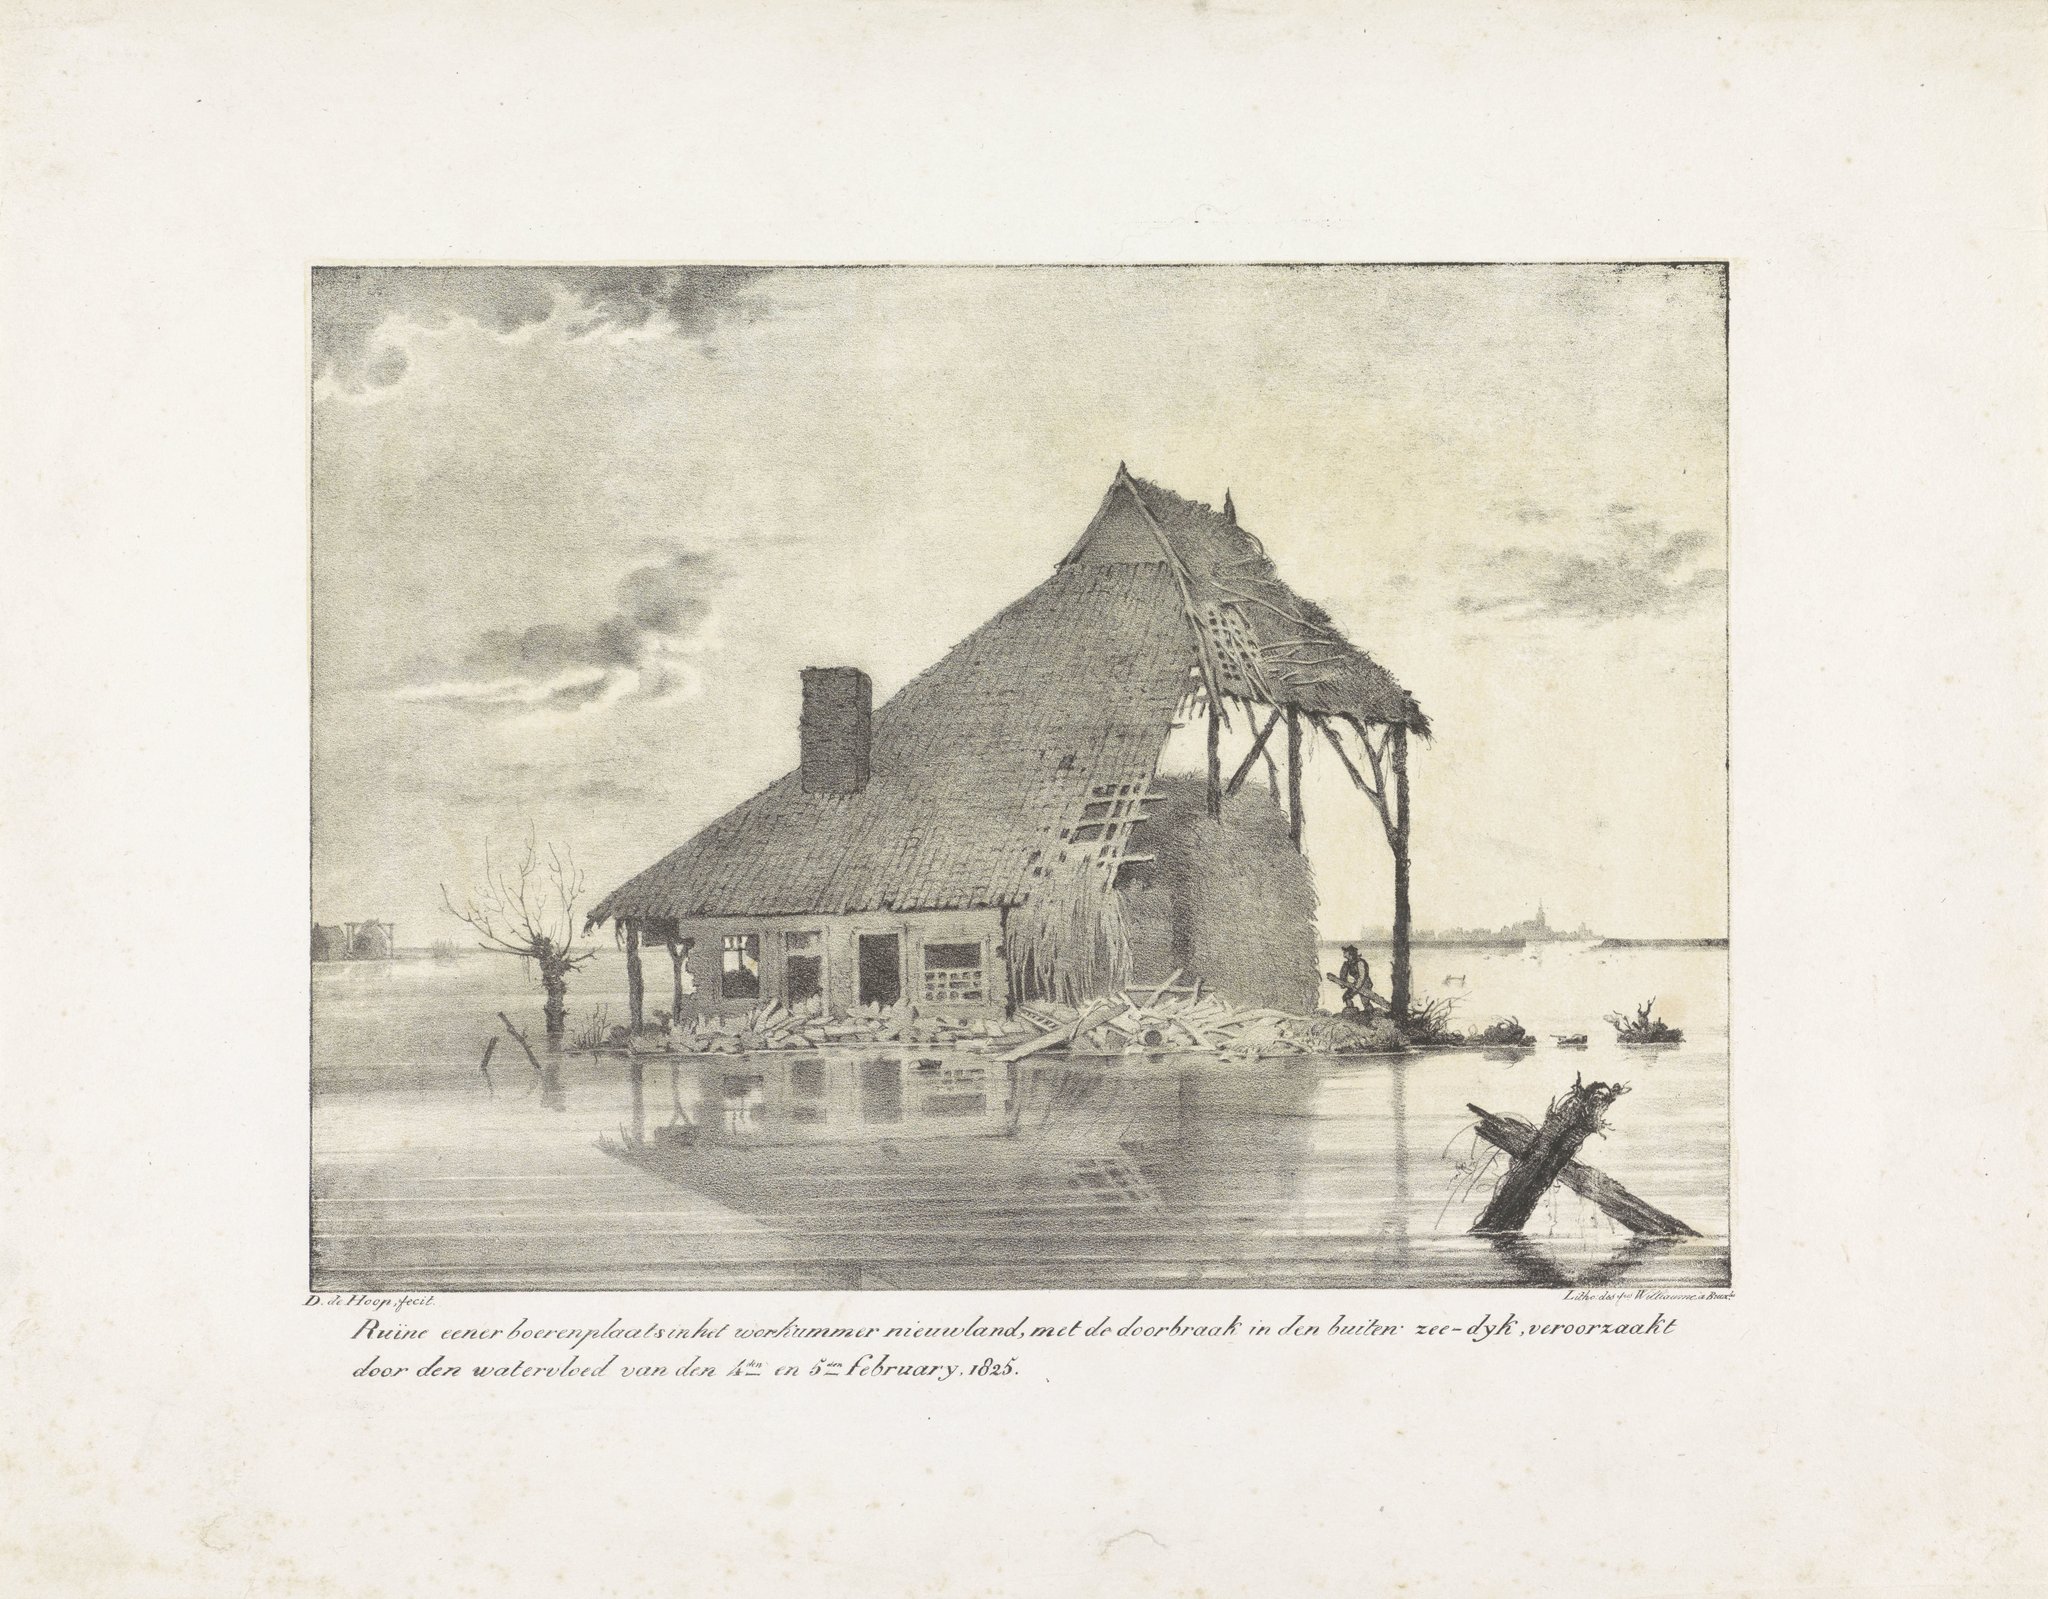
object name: print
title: Ruïne van een boerderij in Friesland, 1825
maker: douwe de hoop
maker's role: draughtsman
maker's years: 1800-1830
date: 1825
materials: paper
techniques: tone lithography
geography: brussels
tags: flood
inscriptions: collector's mark: Lugt 2228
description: Resten van een grotendeels weggespoelde boerderij in stil water, na doorbraak van de oude zeedijk bij Workum in Friesland tijdens de watersnood op 4-5 februari 1825. Zie ook de pendant.